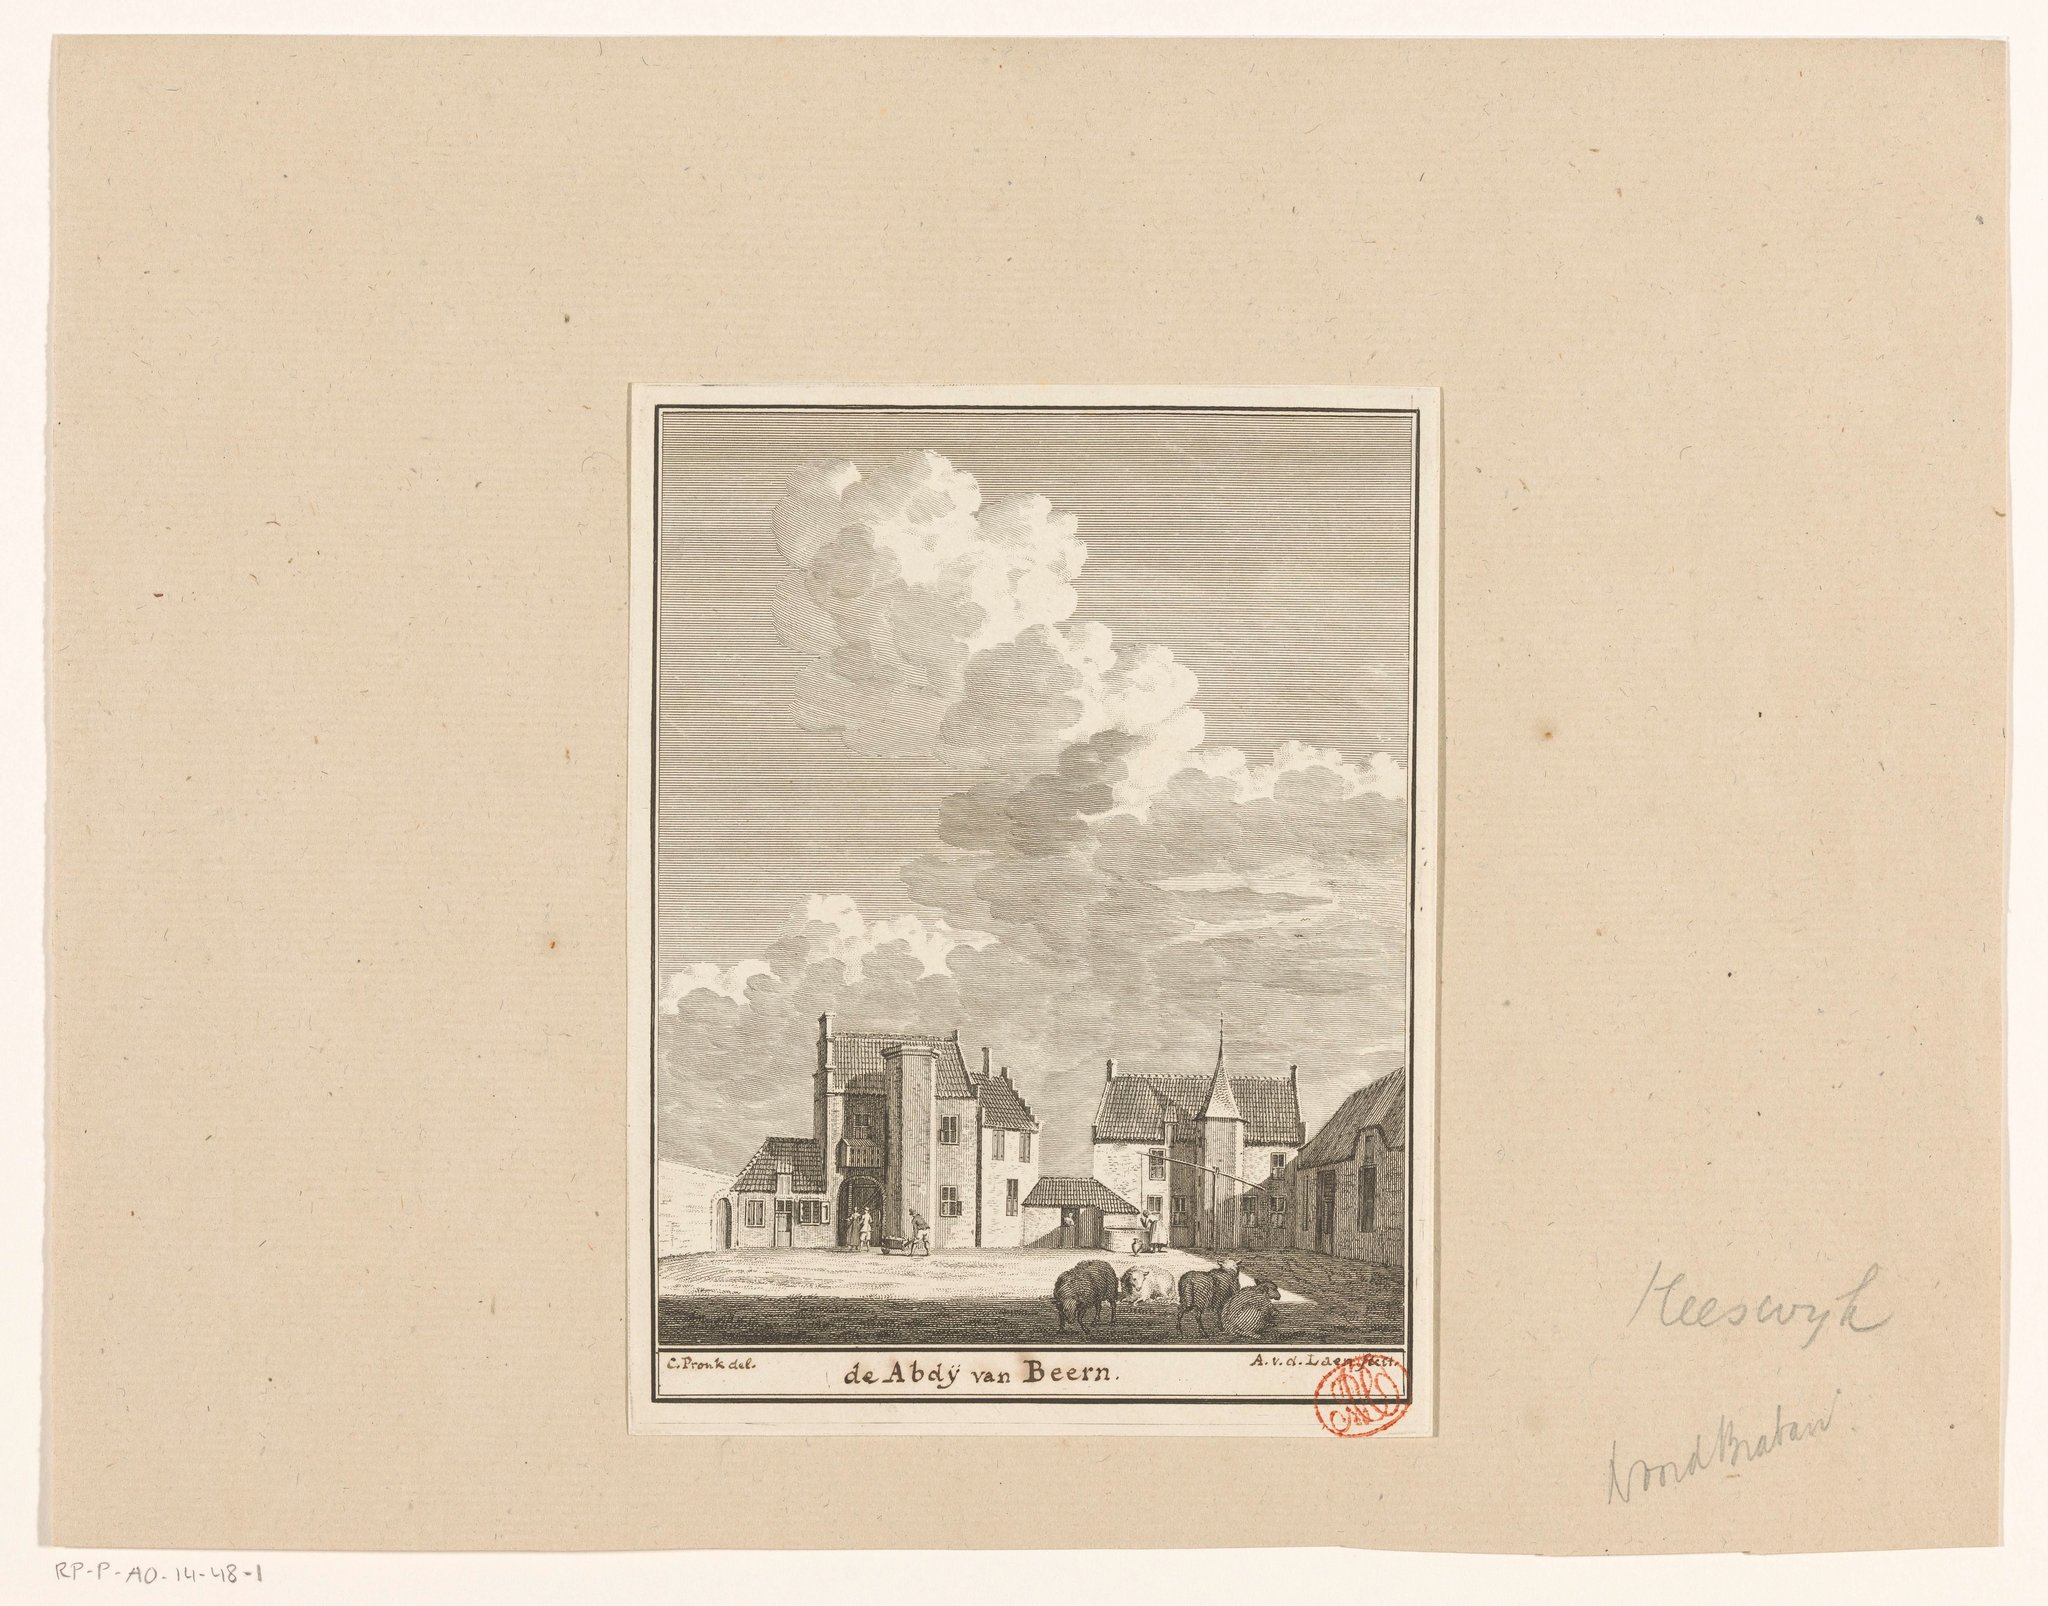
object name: print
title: De Abdij van Beern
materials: ink, paper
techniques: etching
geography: amsterdam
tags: abbey, monastery, convent ~ roman catholic church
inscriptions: collector's mark: Lugt 195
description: Waarschijnlijk verschenen in een toevoeging (over de landen van Heusden) aan: Oudenhoven, Jacobus van. Beschryvinge der stadt Heusden, waar in het begin, aanwasch, en tegenwoordige staat dier stadt verhaalt worden (…) en met konstige figuren verciert. Amsterdam: Jan Hartig, 1743.